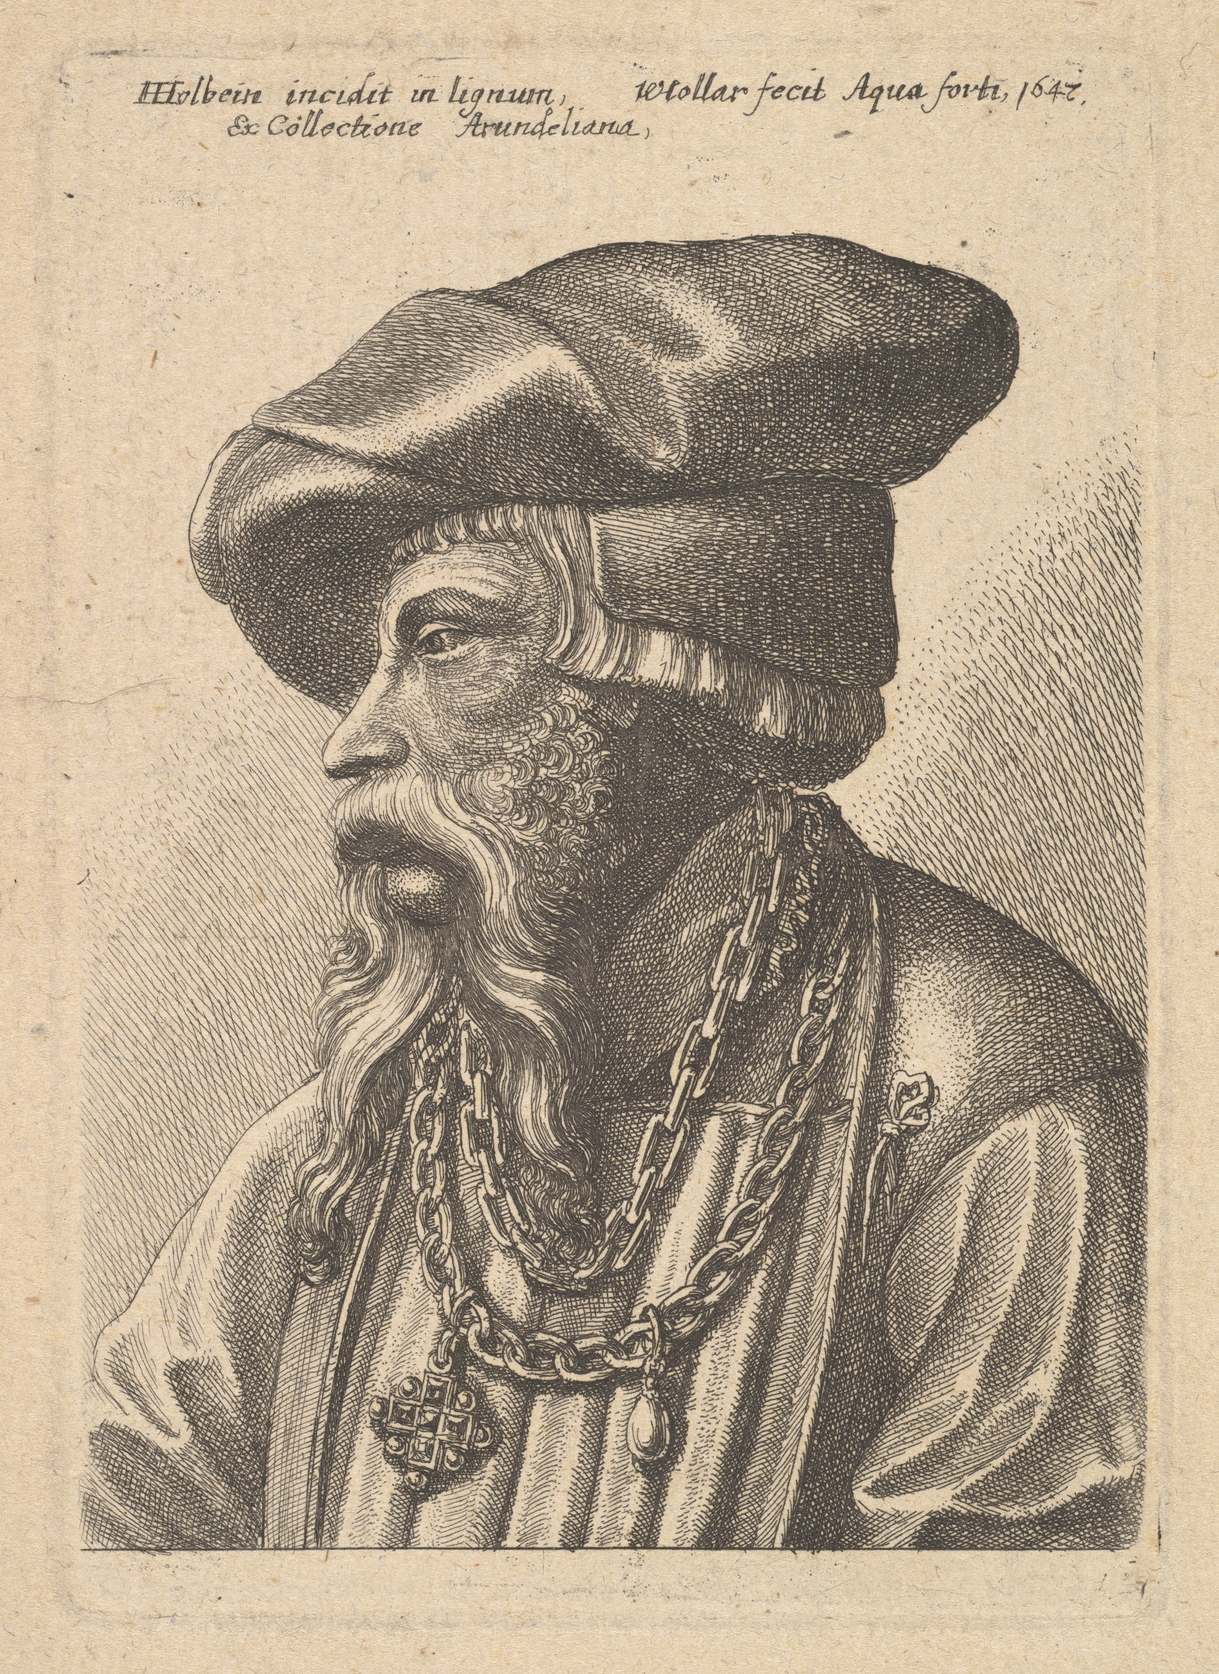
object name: print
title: Bearded man with chain necklace, possibly from "A Collection of Original Etchings"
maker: wenceslaus hollar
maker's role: artist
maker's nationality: bohemian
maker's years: 1607-1677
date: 1647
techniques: etching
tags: men,profiles